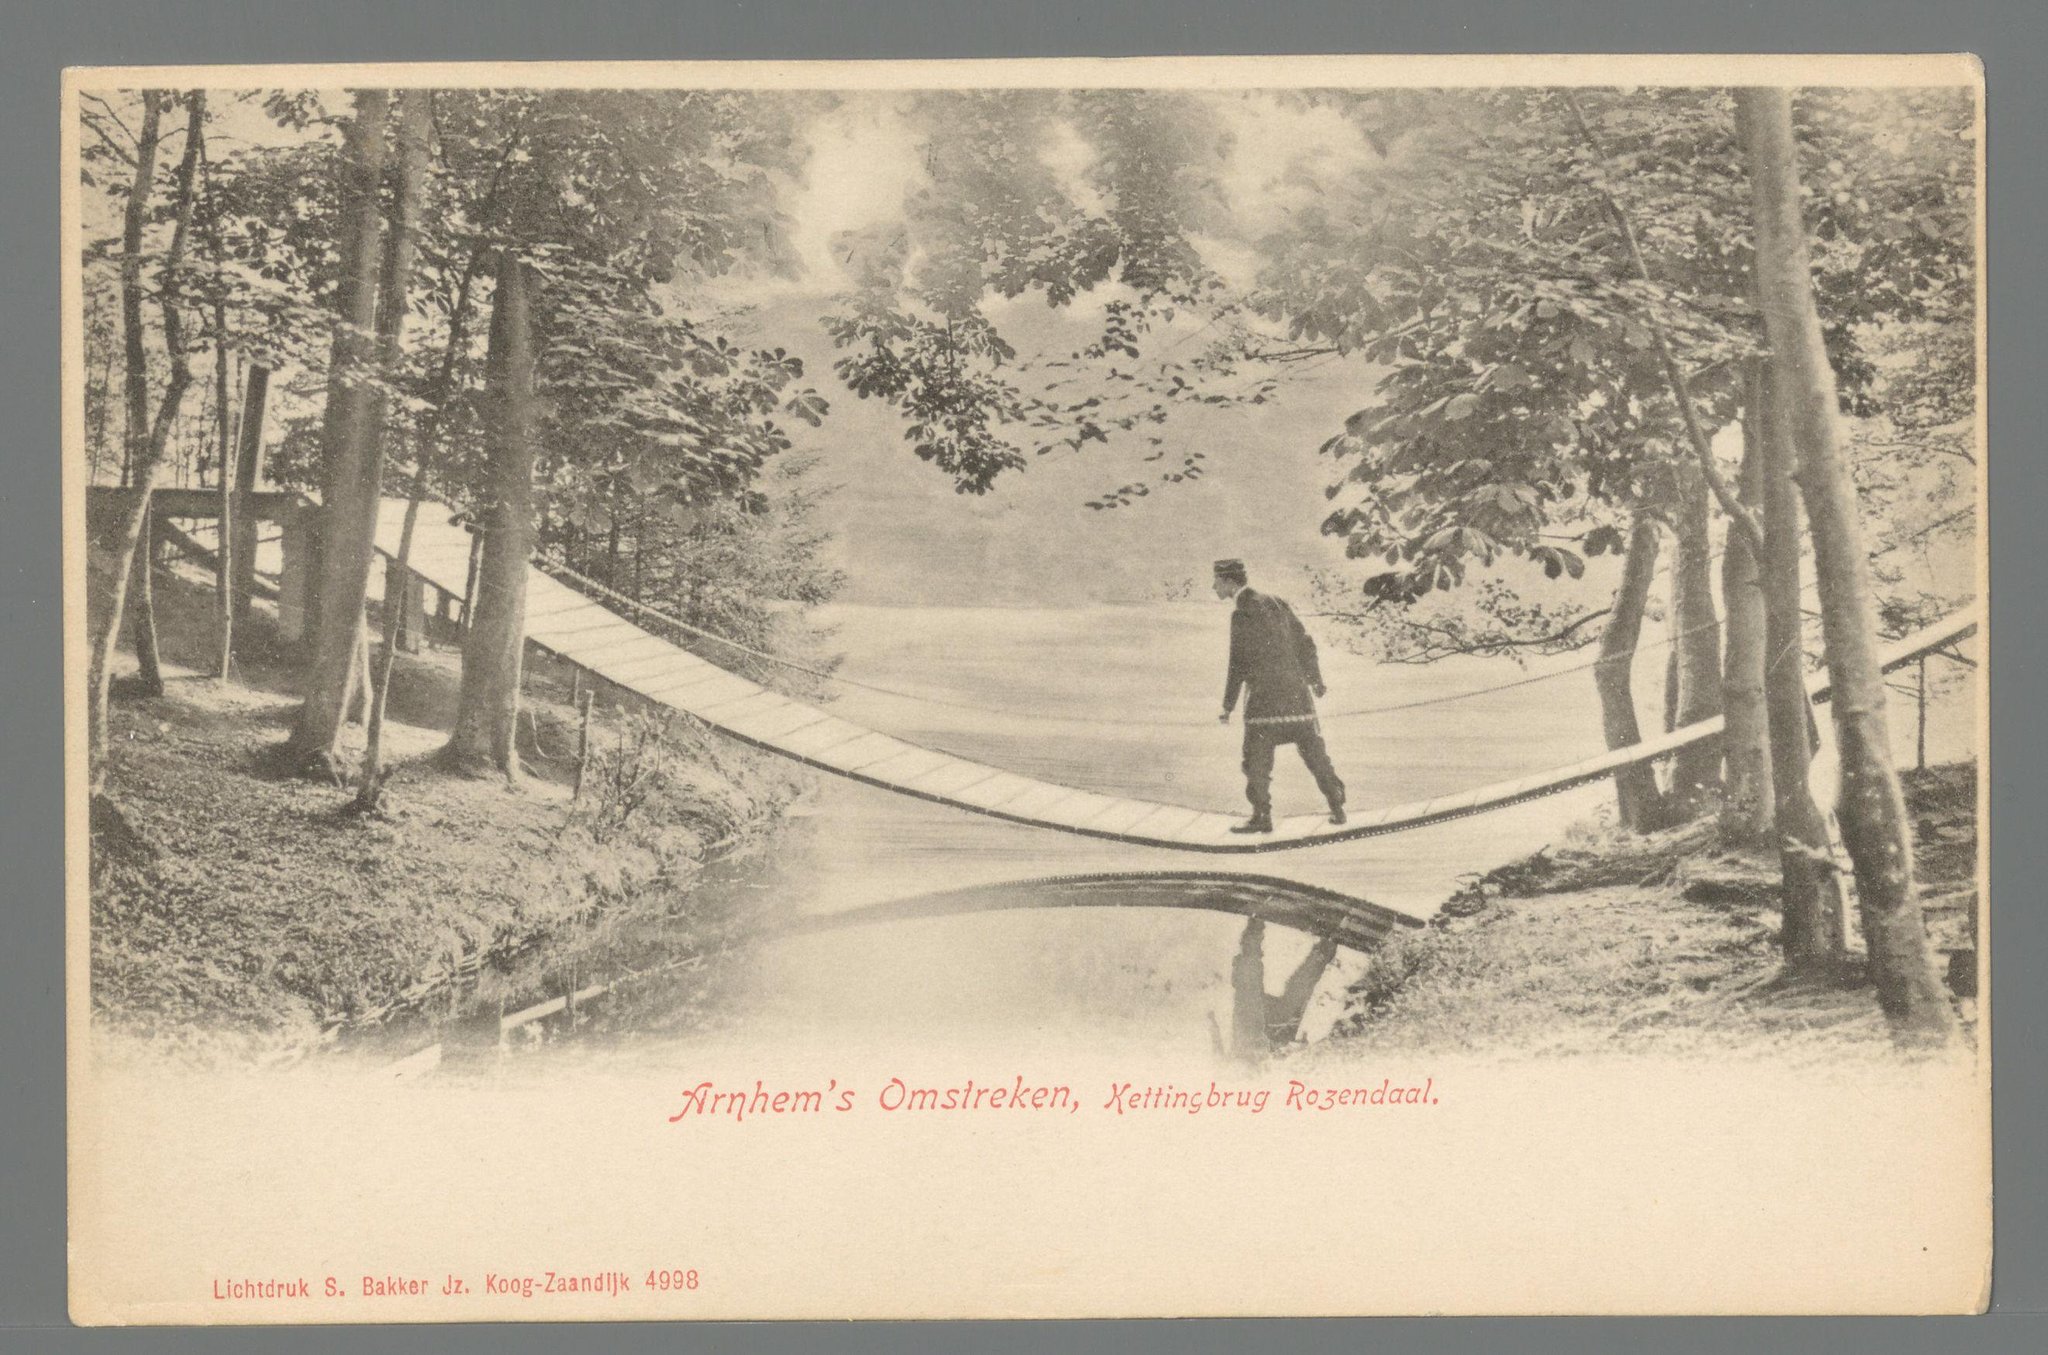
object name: photomechanical print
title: Arnhem's Omstreken, Kettingbrug Rozendaal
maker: simon bakker jz.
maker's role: printer, publisher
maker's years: 1873-1930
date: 1899-1905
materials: cardboard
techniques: photograph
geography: koog aan de zaan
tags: canal, bridge